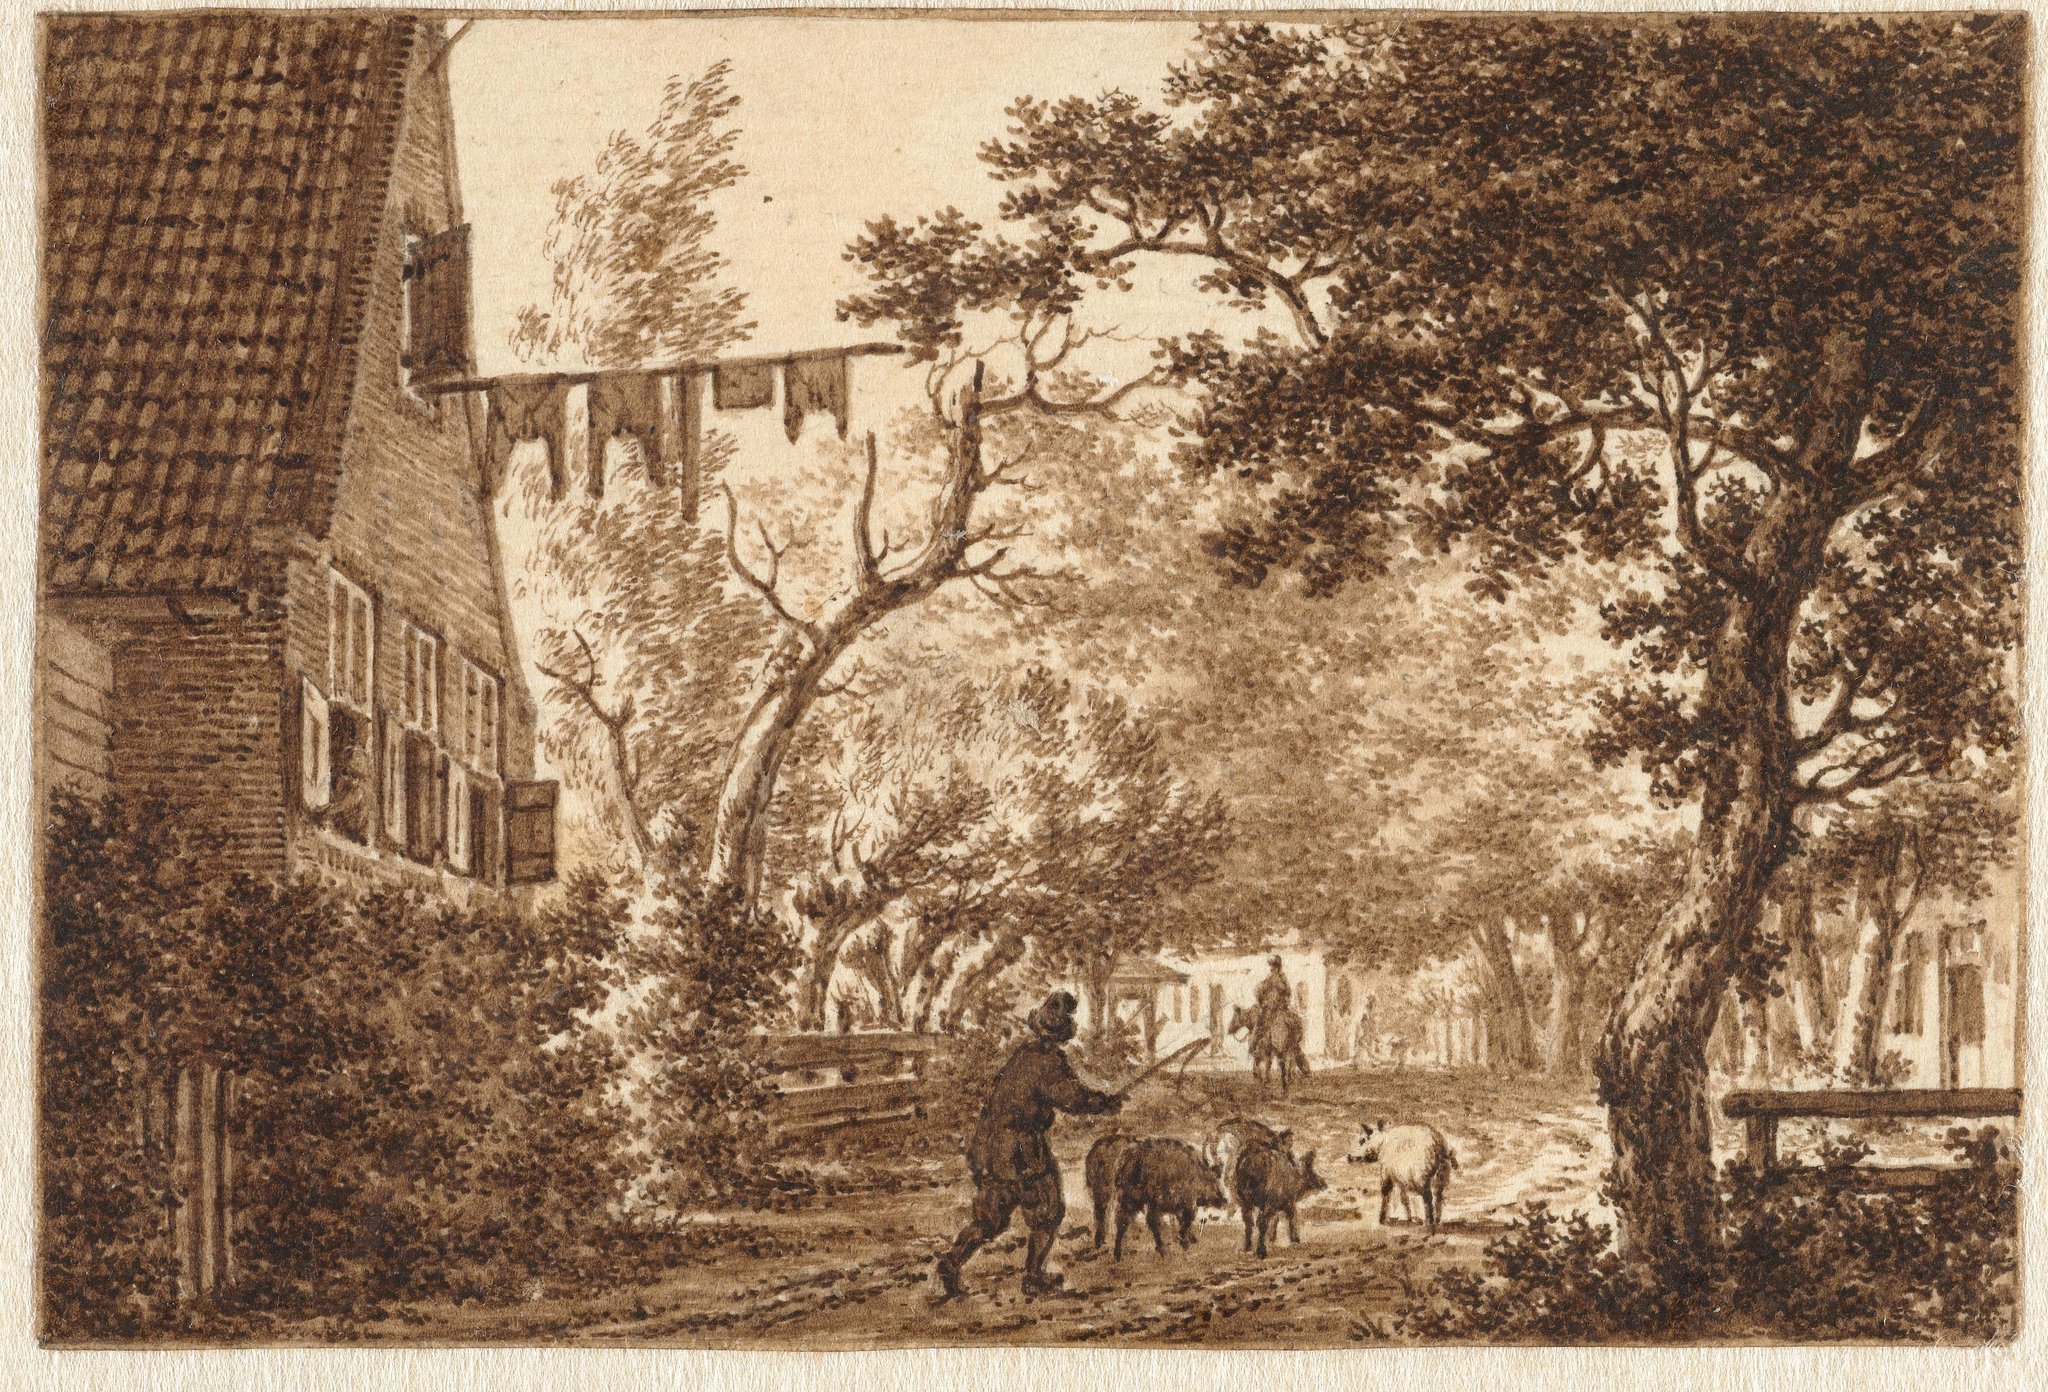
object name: drawing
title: Varkenshoeder op weggetje voor een huis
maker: jacob cats (1741-1799)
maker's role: draughtsman, print maker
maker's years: 1741-1799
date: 1776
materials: ink, paper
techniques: brush, pen